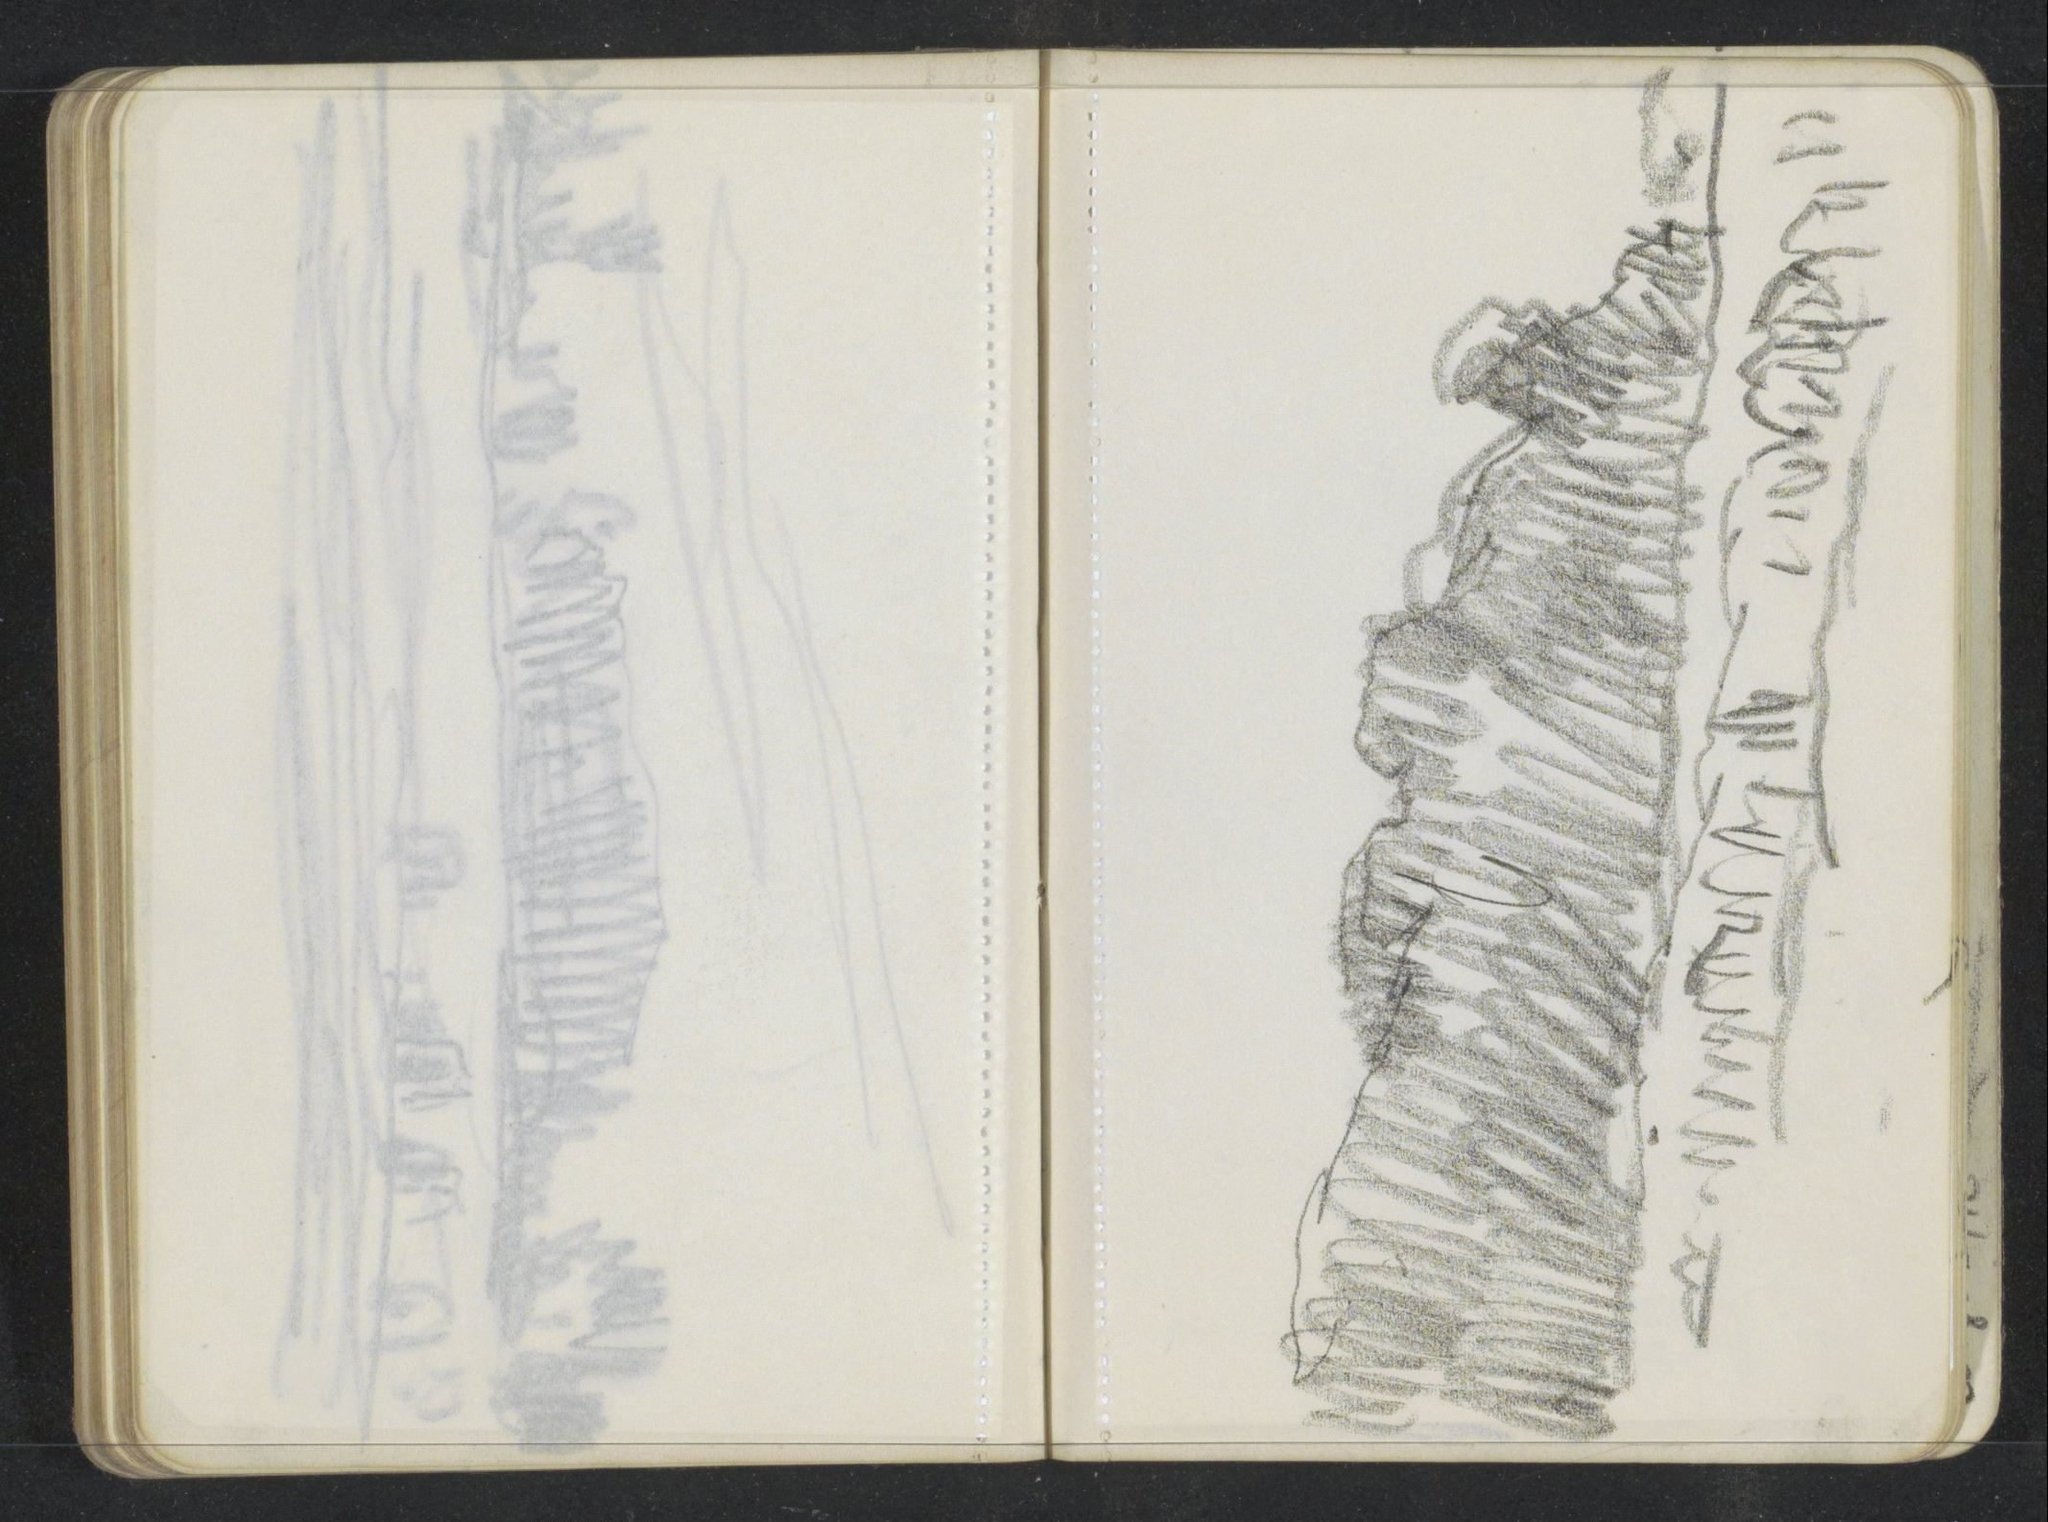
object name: sketchbook leaf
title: Landschap met bomen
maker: alexander shilling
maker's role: draughtsman, print maker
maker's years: 1859-1937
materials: paper, pencil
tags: trees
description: Blad 61 recto uit een schetsboek met 91 bladen.